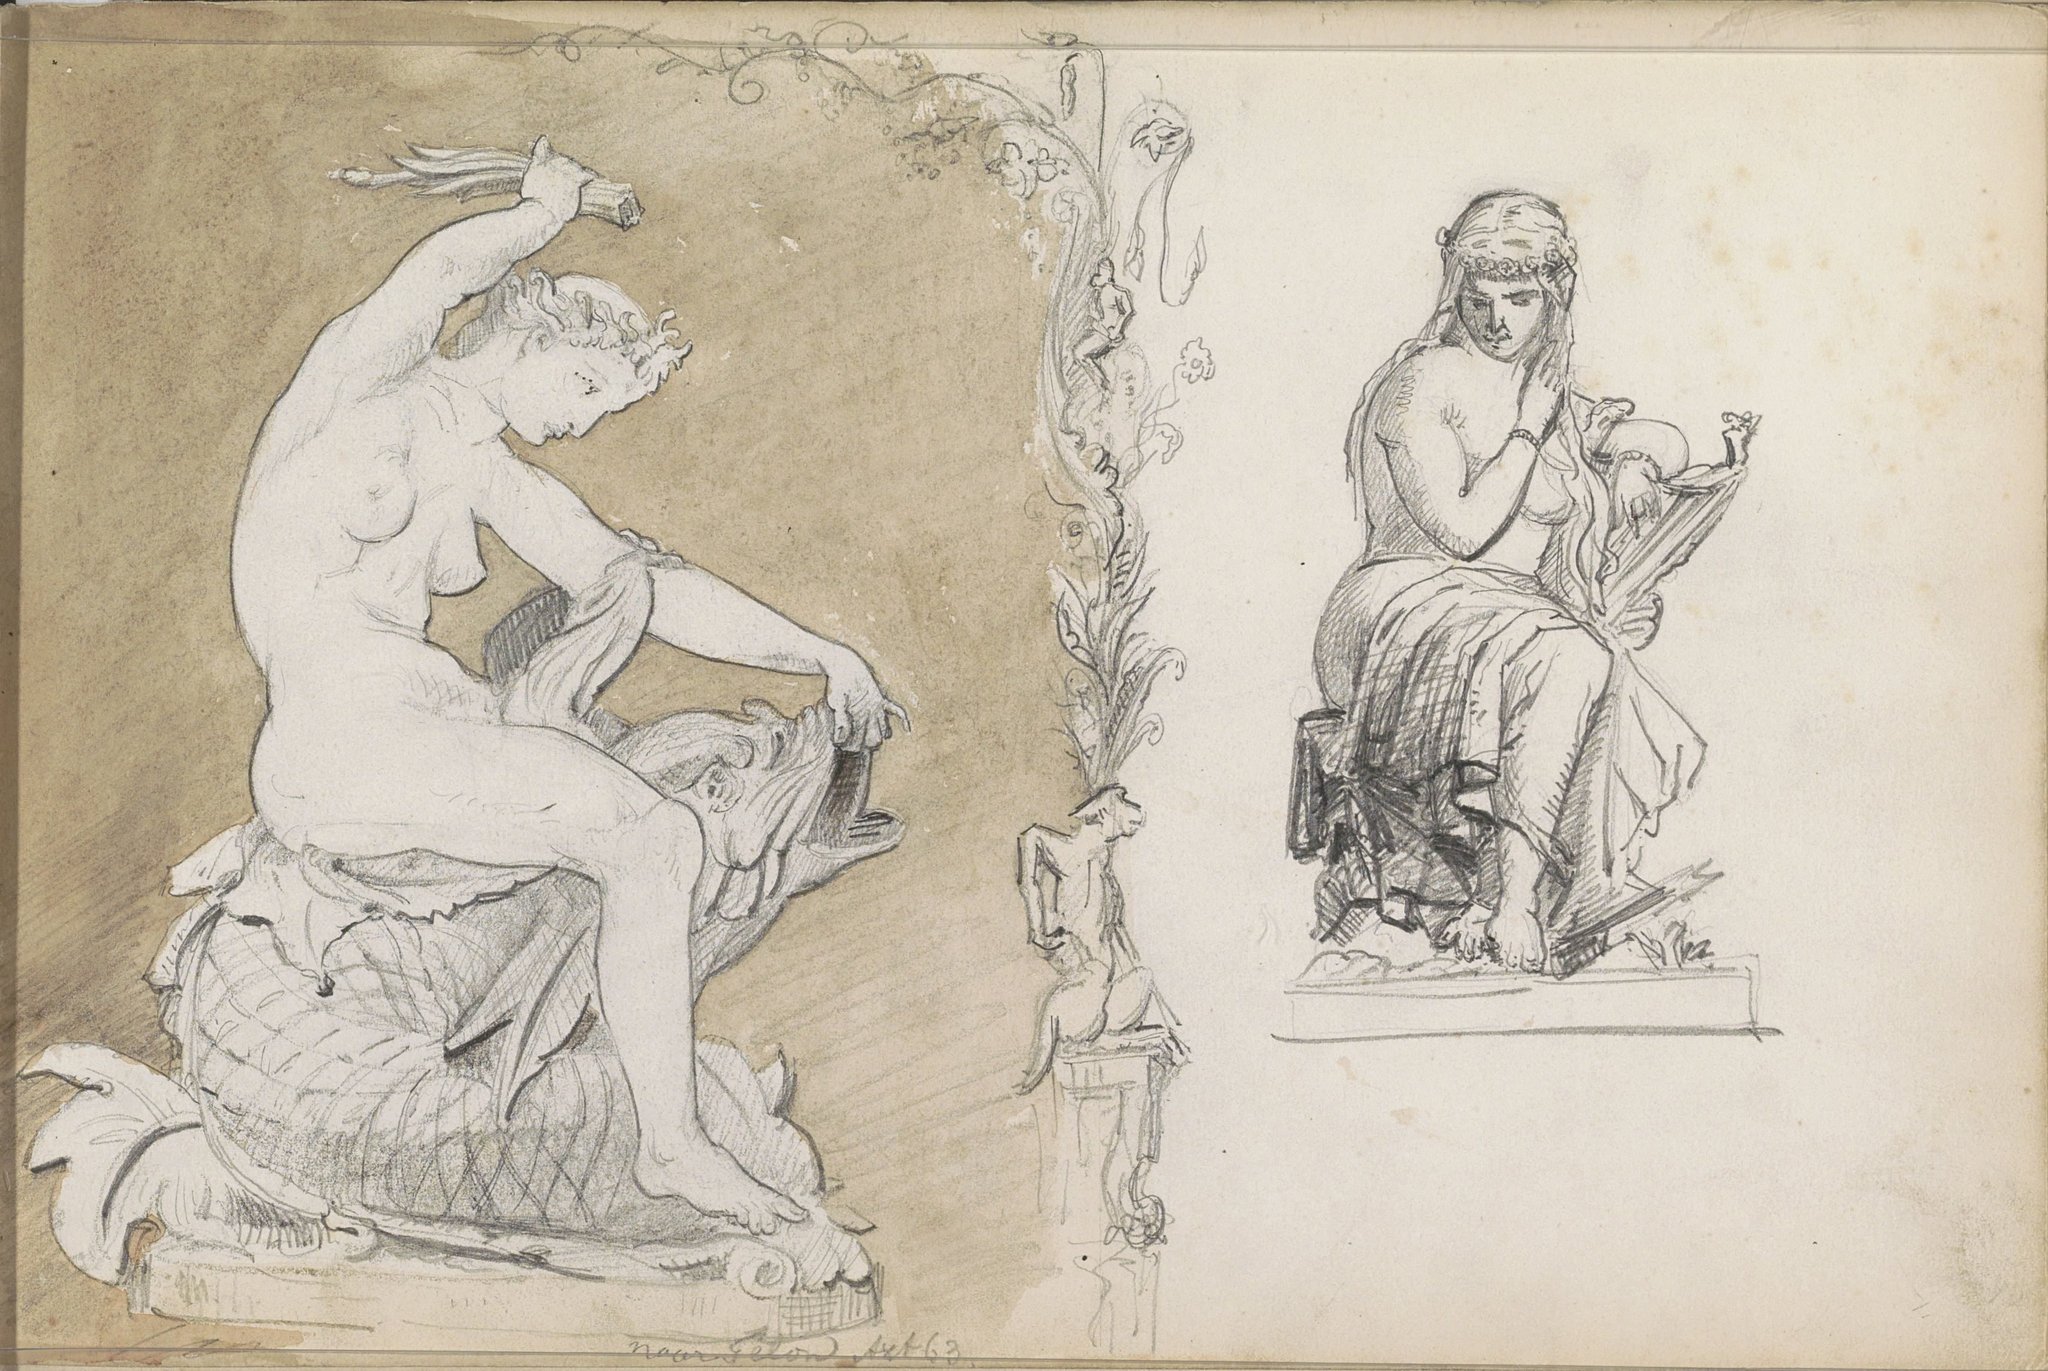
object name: sketchbook leaf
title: Twee sculpturen van naakte vrouwen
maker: isaac gosschalk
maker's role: draughtsman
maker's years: 1838-1907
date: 1863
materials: paper, pencil, watercolor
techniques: brush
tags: sculpture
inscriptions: date and inscription: ‘naar Gelon(?) Art 63.’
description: Studies van een naakte vrouw zittend op een waterdier, mogelijk een vis, en van een zittende naakte vrouw met een doek om haar benen gedrapeerd. Blad 24 recto uit een schetsboek met 58 bladen.